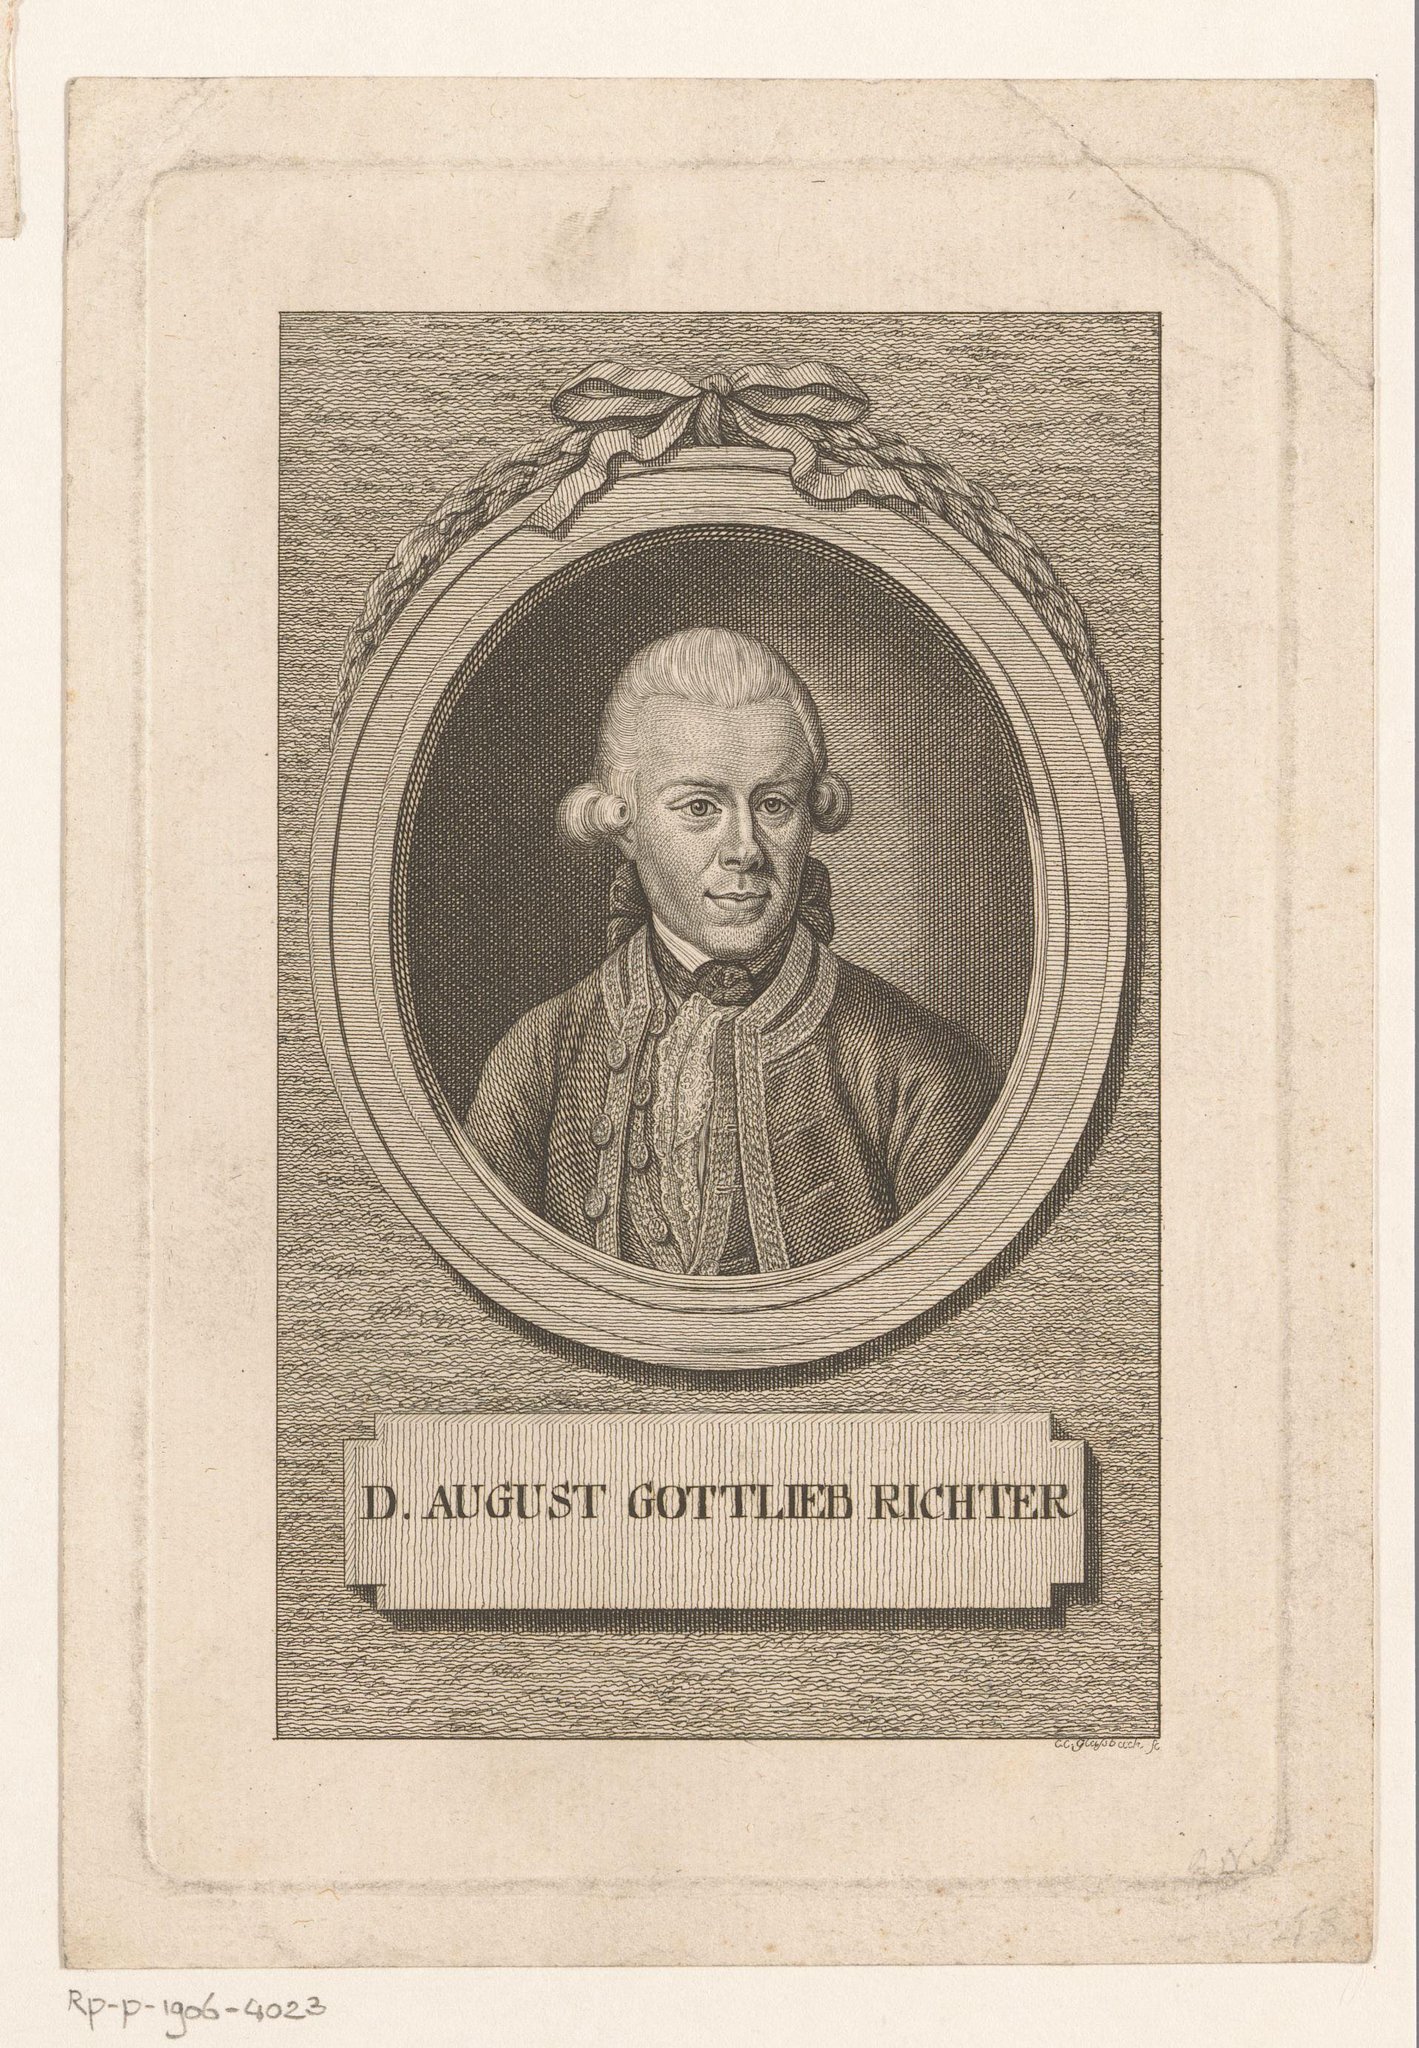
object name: print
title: Portret van August Gottlieb Richter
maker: carl christian glassbach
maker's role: print maker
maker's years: 1751-1789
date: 1761-1789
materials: paper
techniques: engraving, etching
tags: ornament ~ medallion, historical persons, physician, doctor, ornament ~ festoon, garland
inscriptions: collector's mark: Lugt 2228